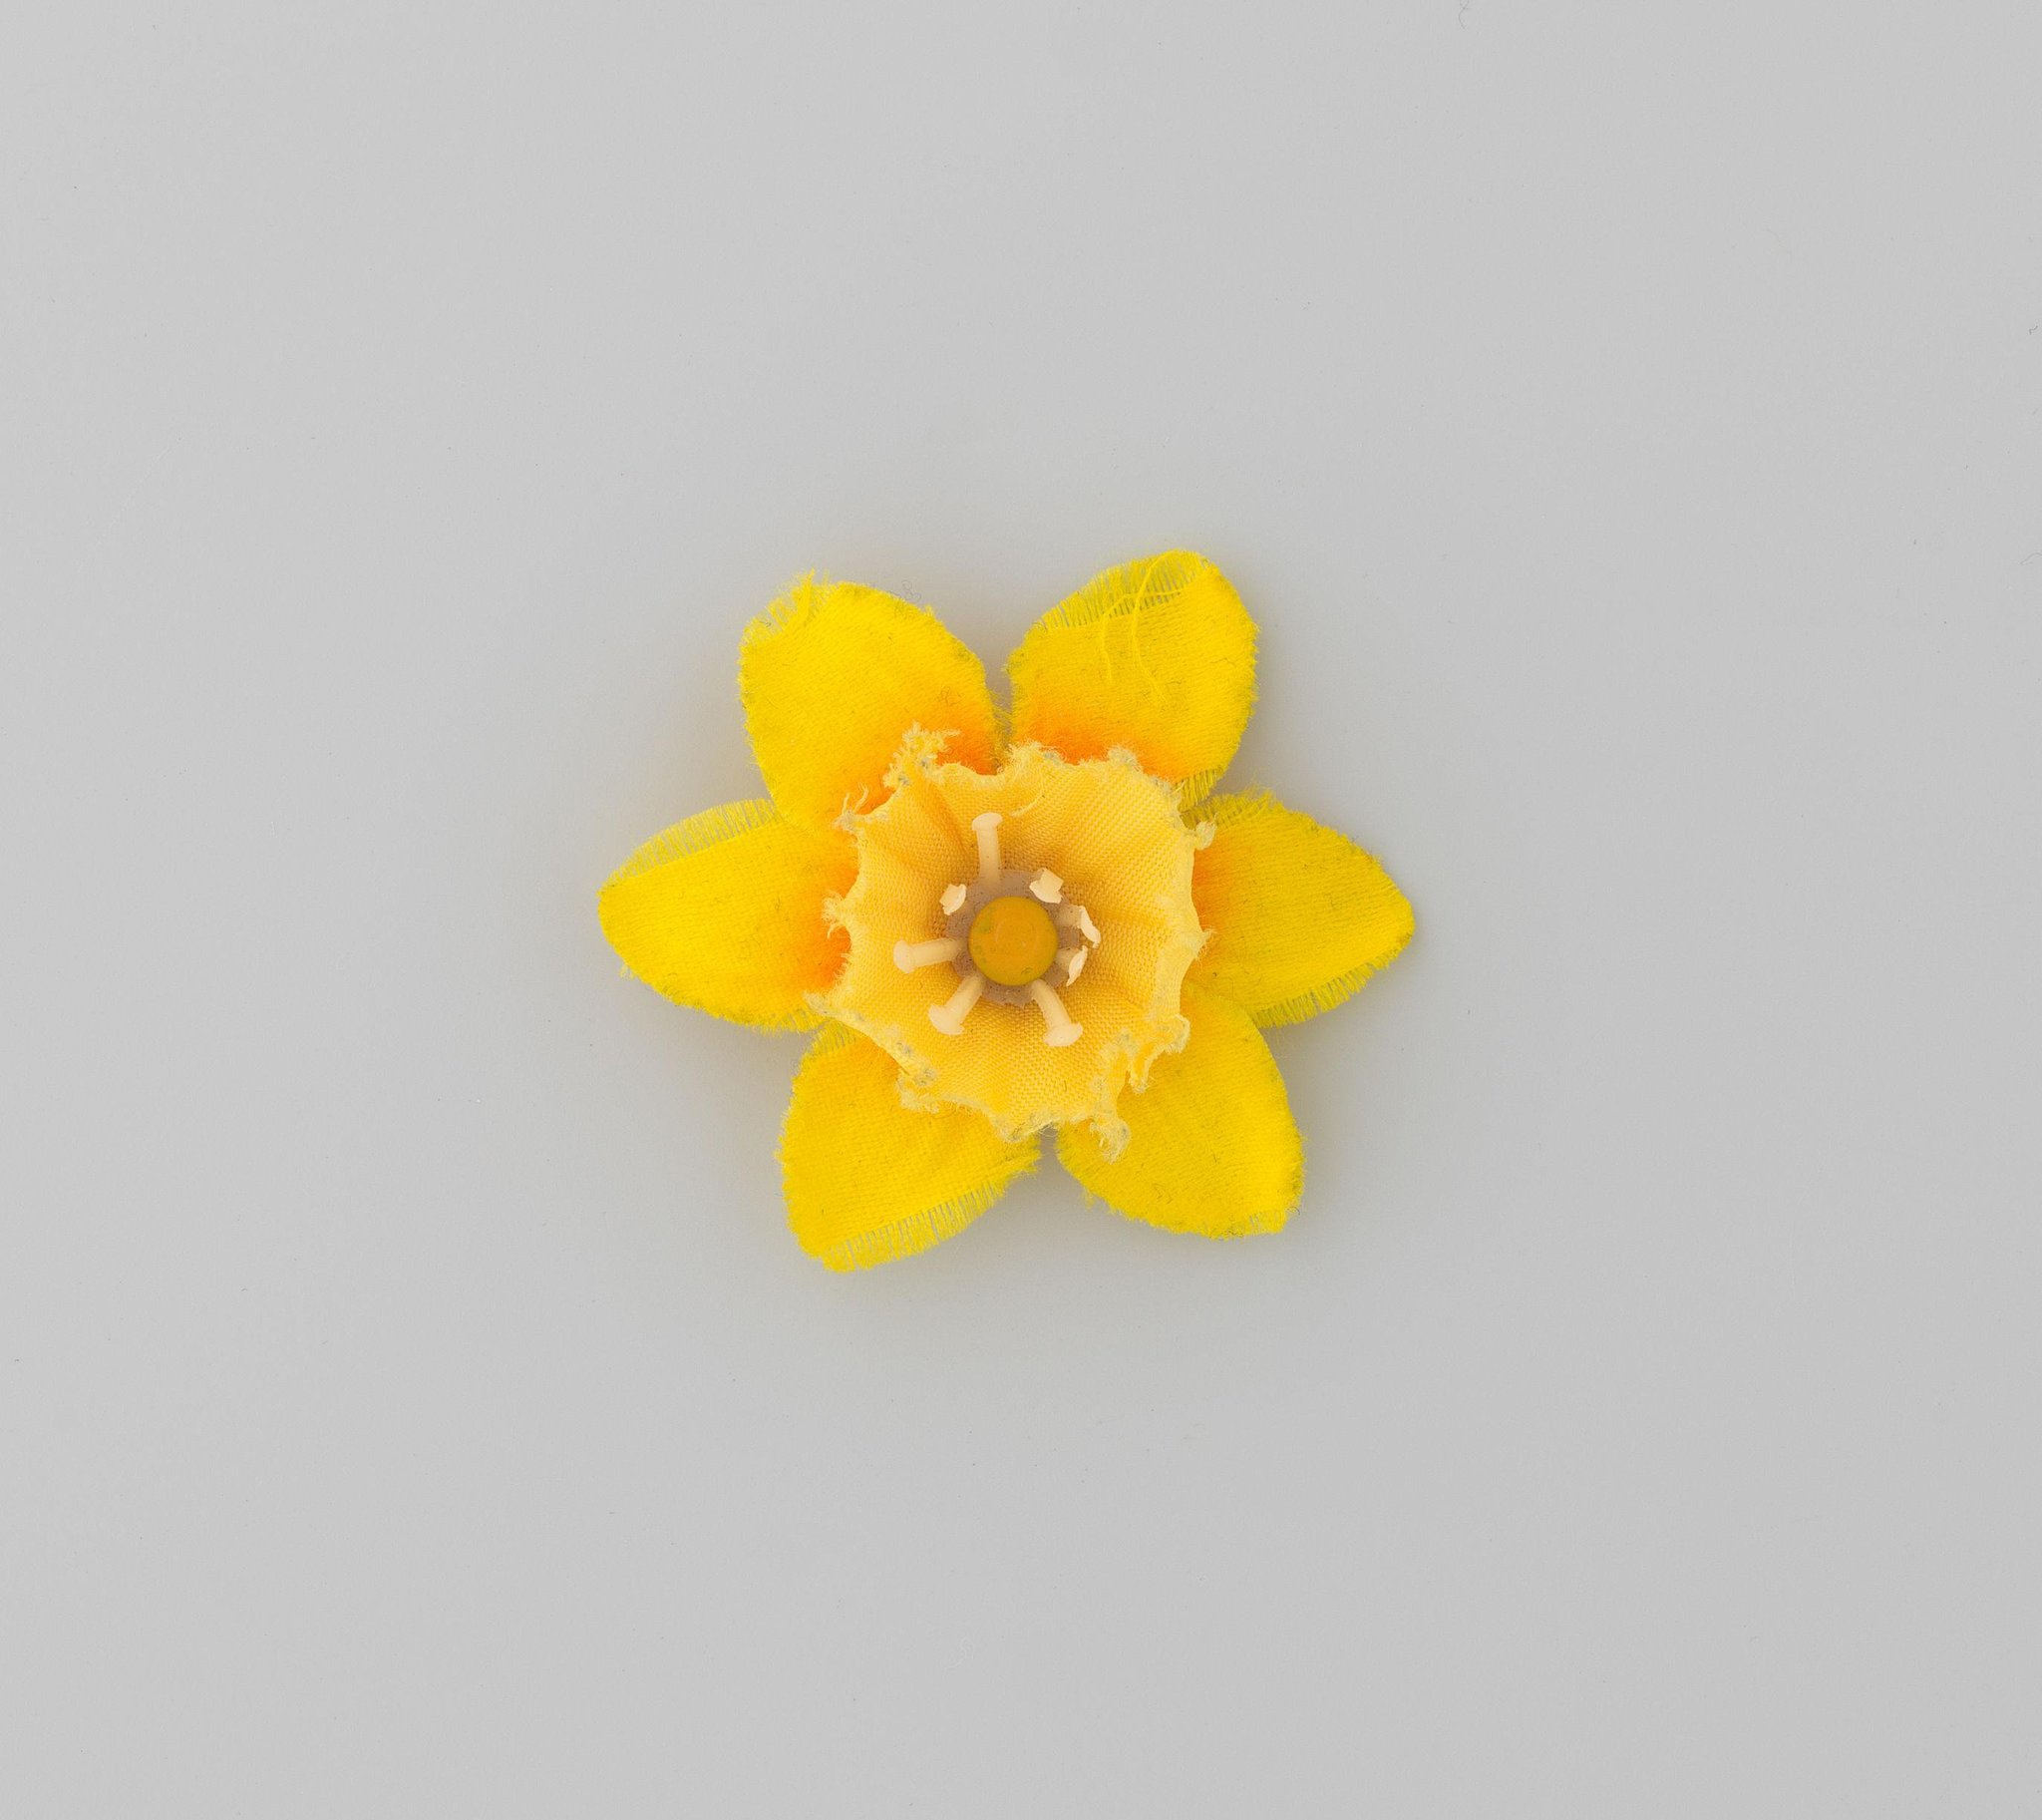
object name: brooch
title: Narcis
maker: Anonymous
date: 1990-2000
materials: plastic, textile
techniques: snipping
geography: new zealand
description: Vanaf 1990 wordt in Nieuw-Zeeland op 25 augustus Daffodil Day gevierd.